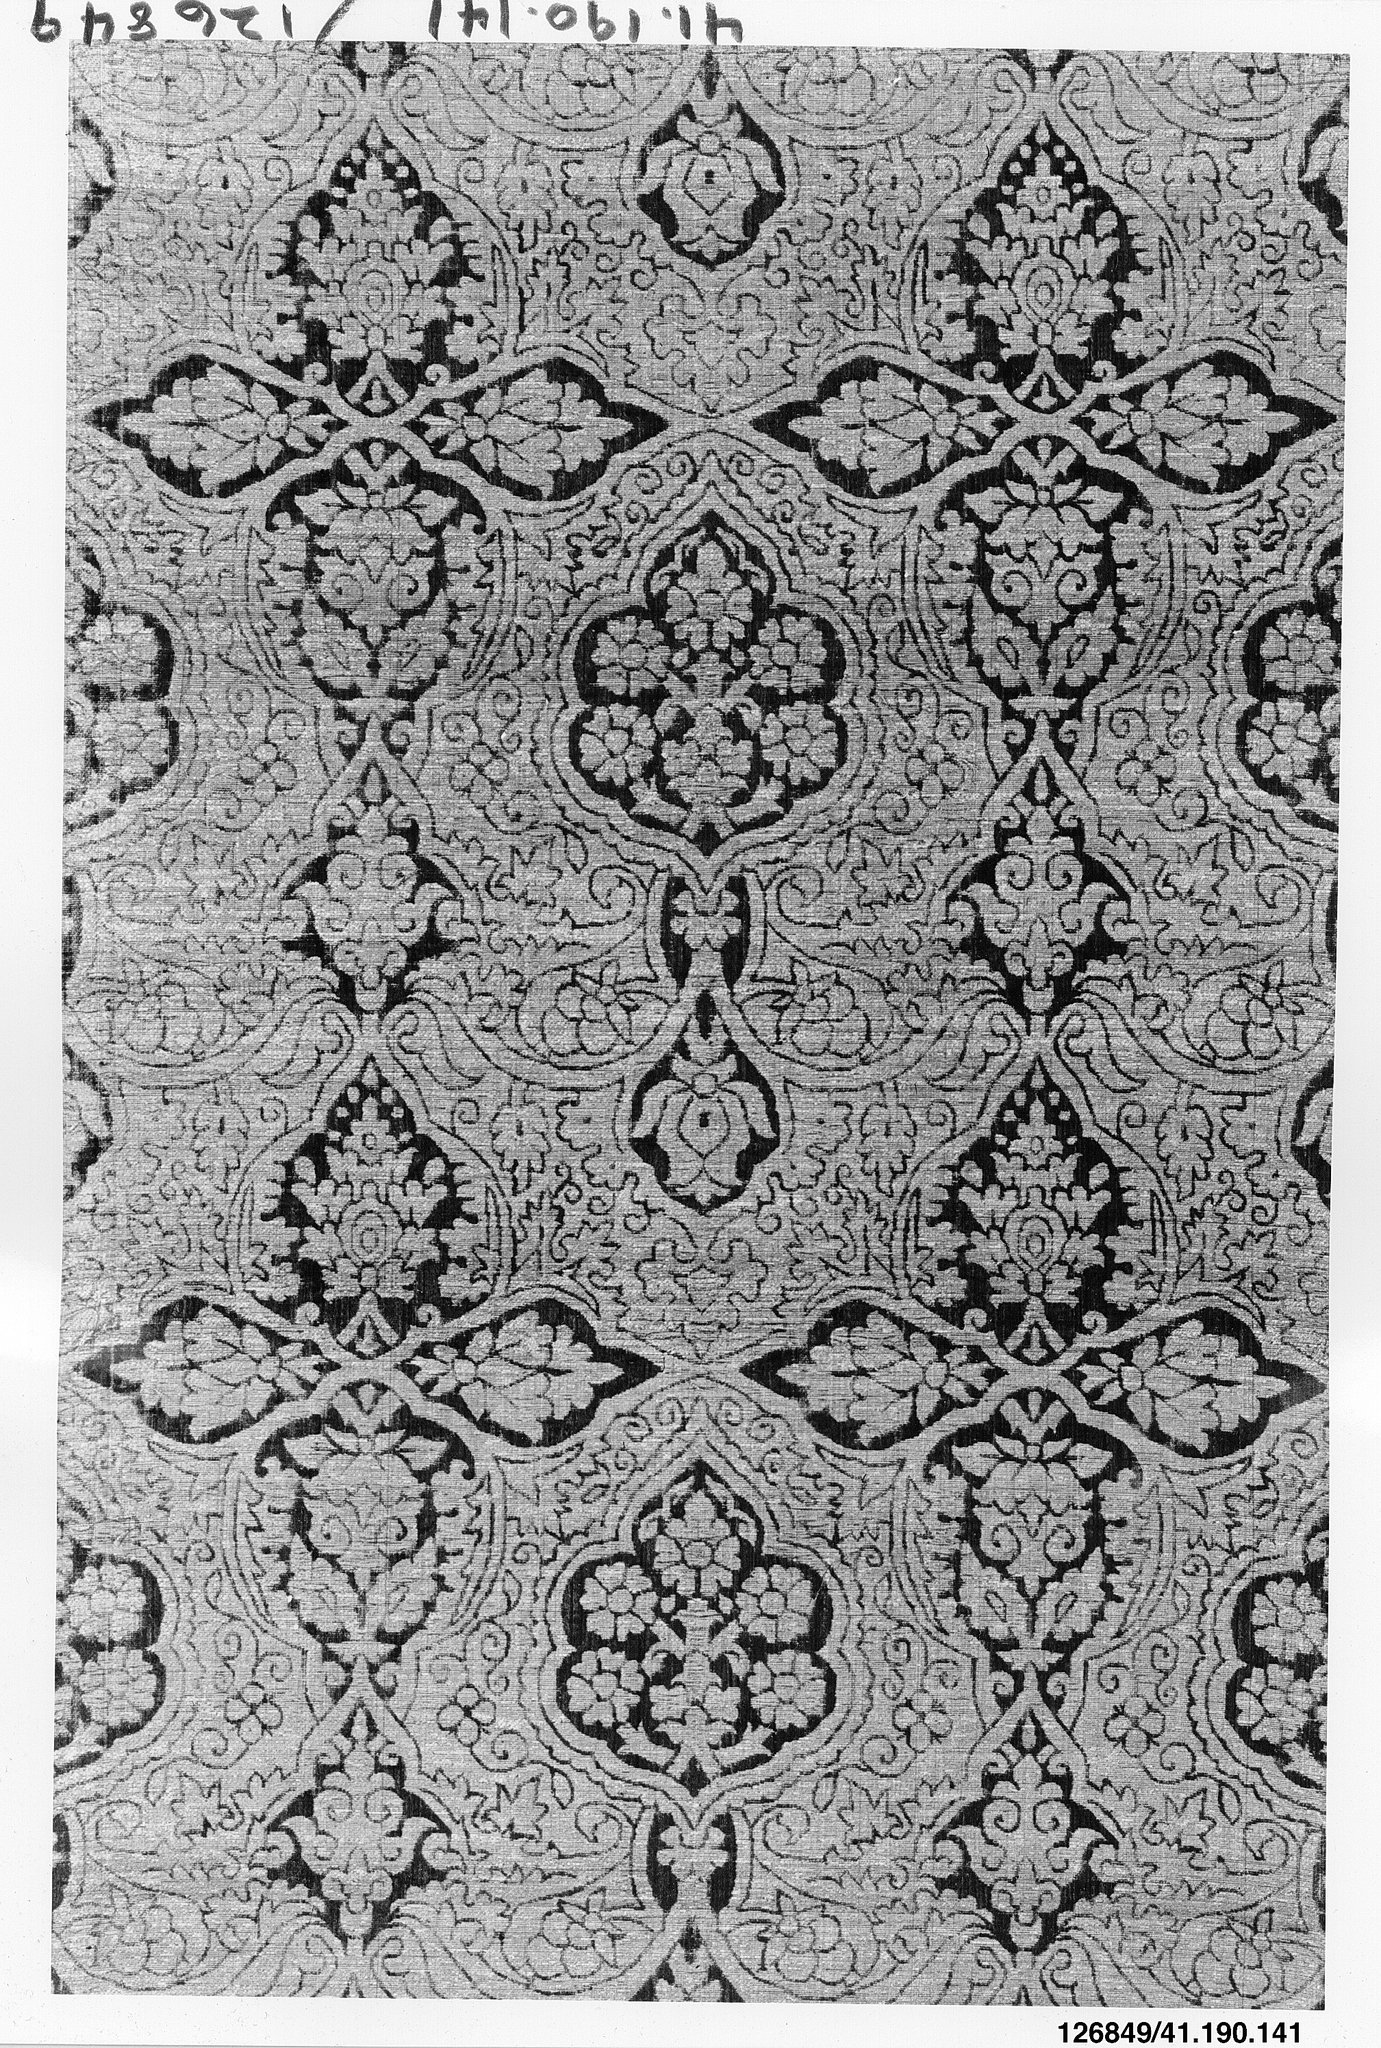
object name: piece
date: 1467-1500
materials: metal thread, silk